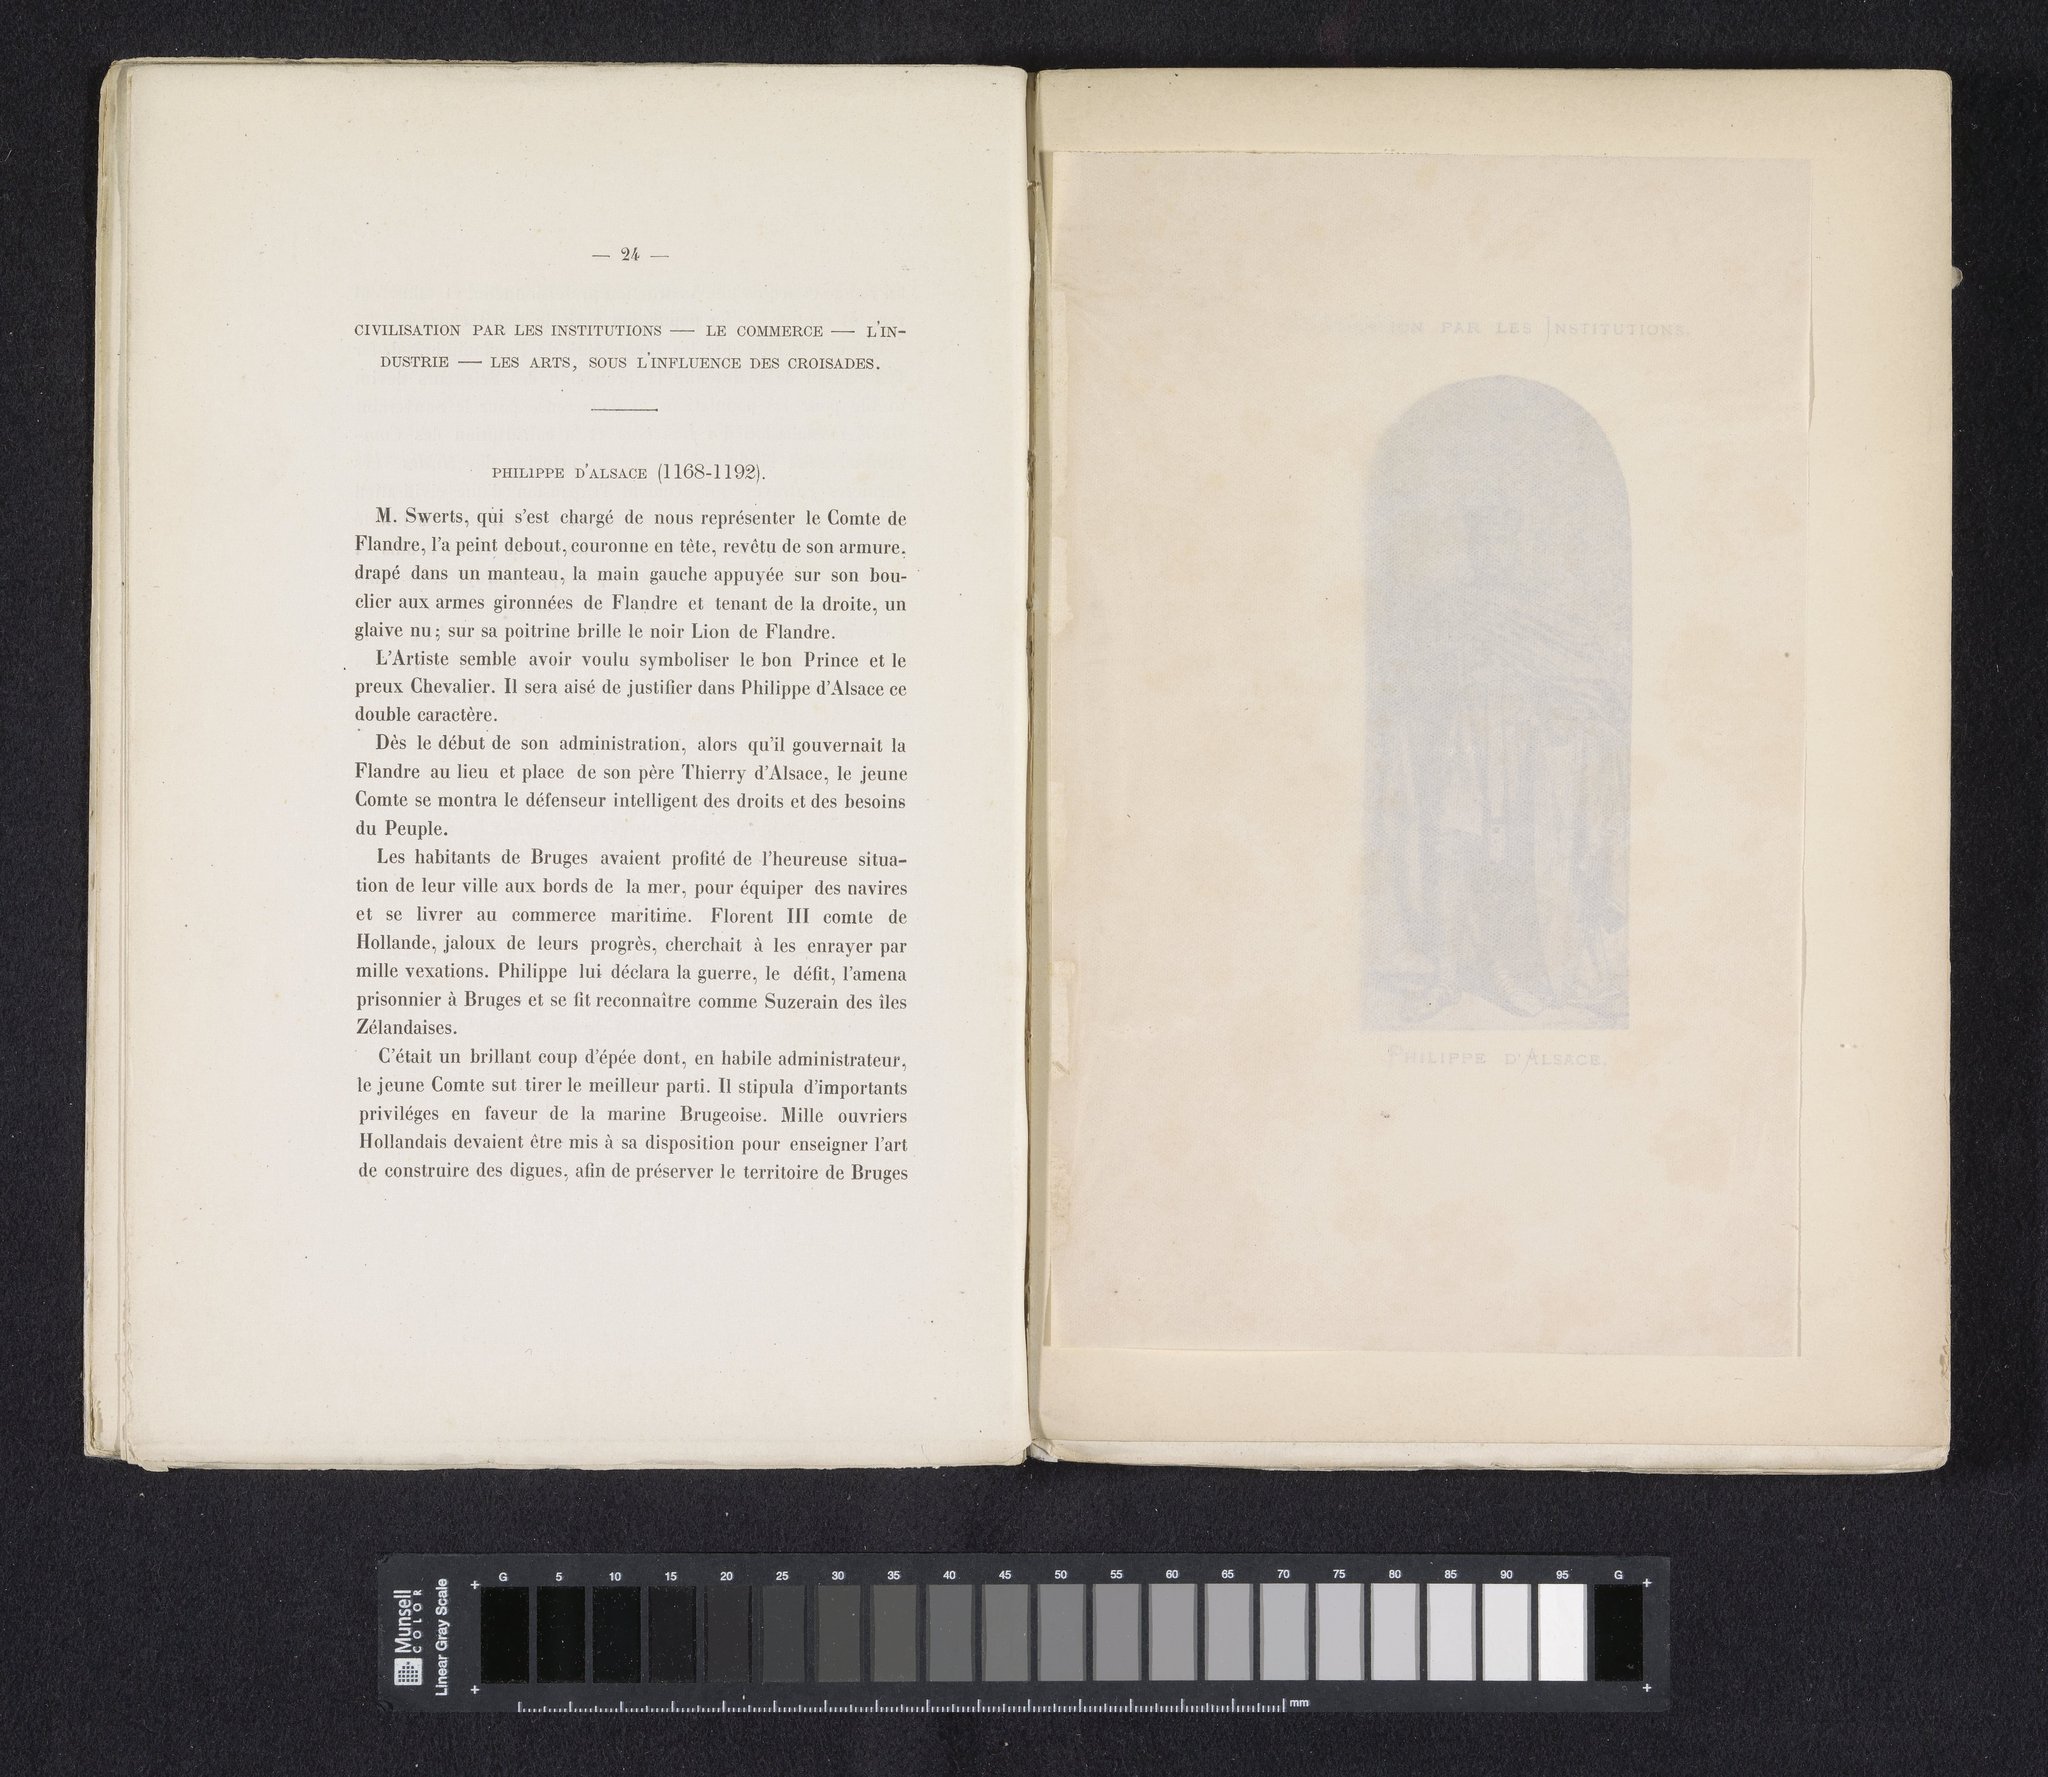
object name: reproduction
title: Philippe d'Alsace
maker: Anonymous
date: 1866-1876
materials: cardboard, paper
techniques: woodburytype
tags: knight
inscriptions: inscription: ‘Civilisation par les Institutions’